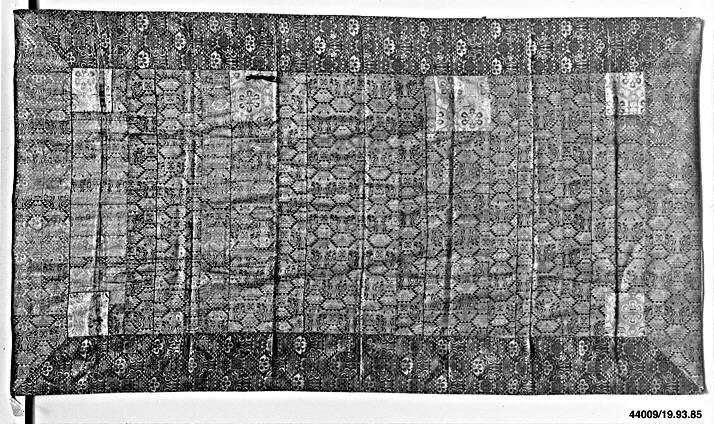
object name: robe, priest's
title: Priest's Robe (Shichijō)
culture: japanese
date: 1600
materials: metal thread, silk